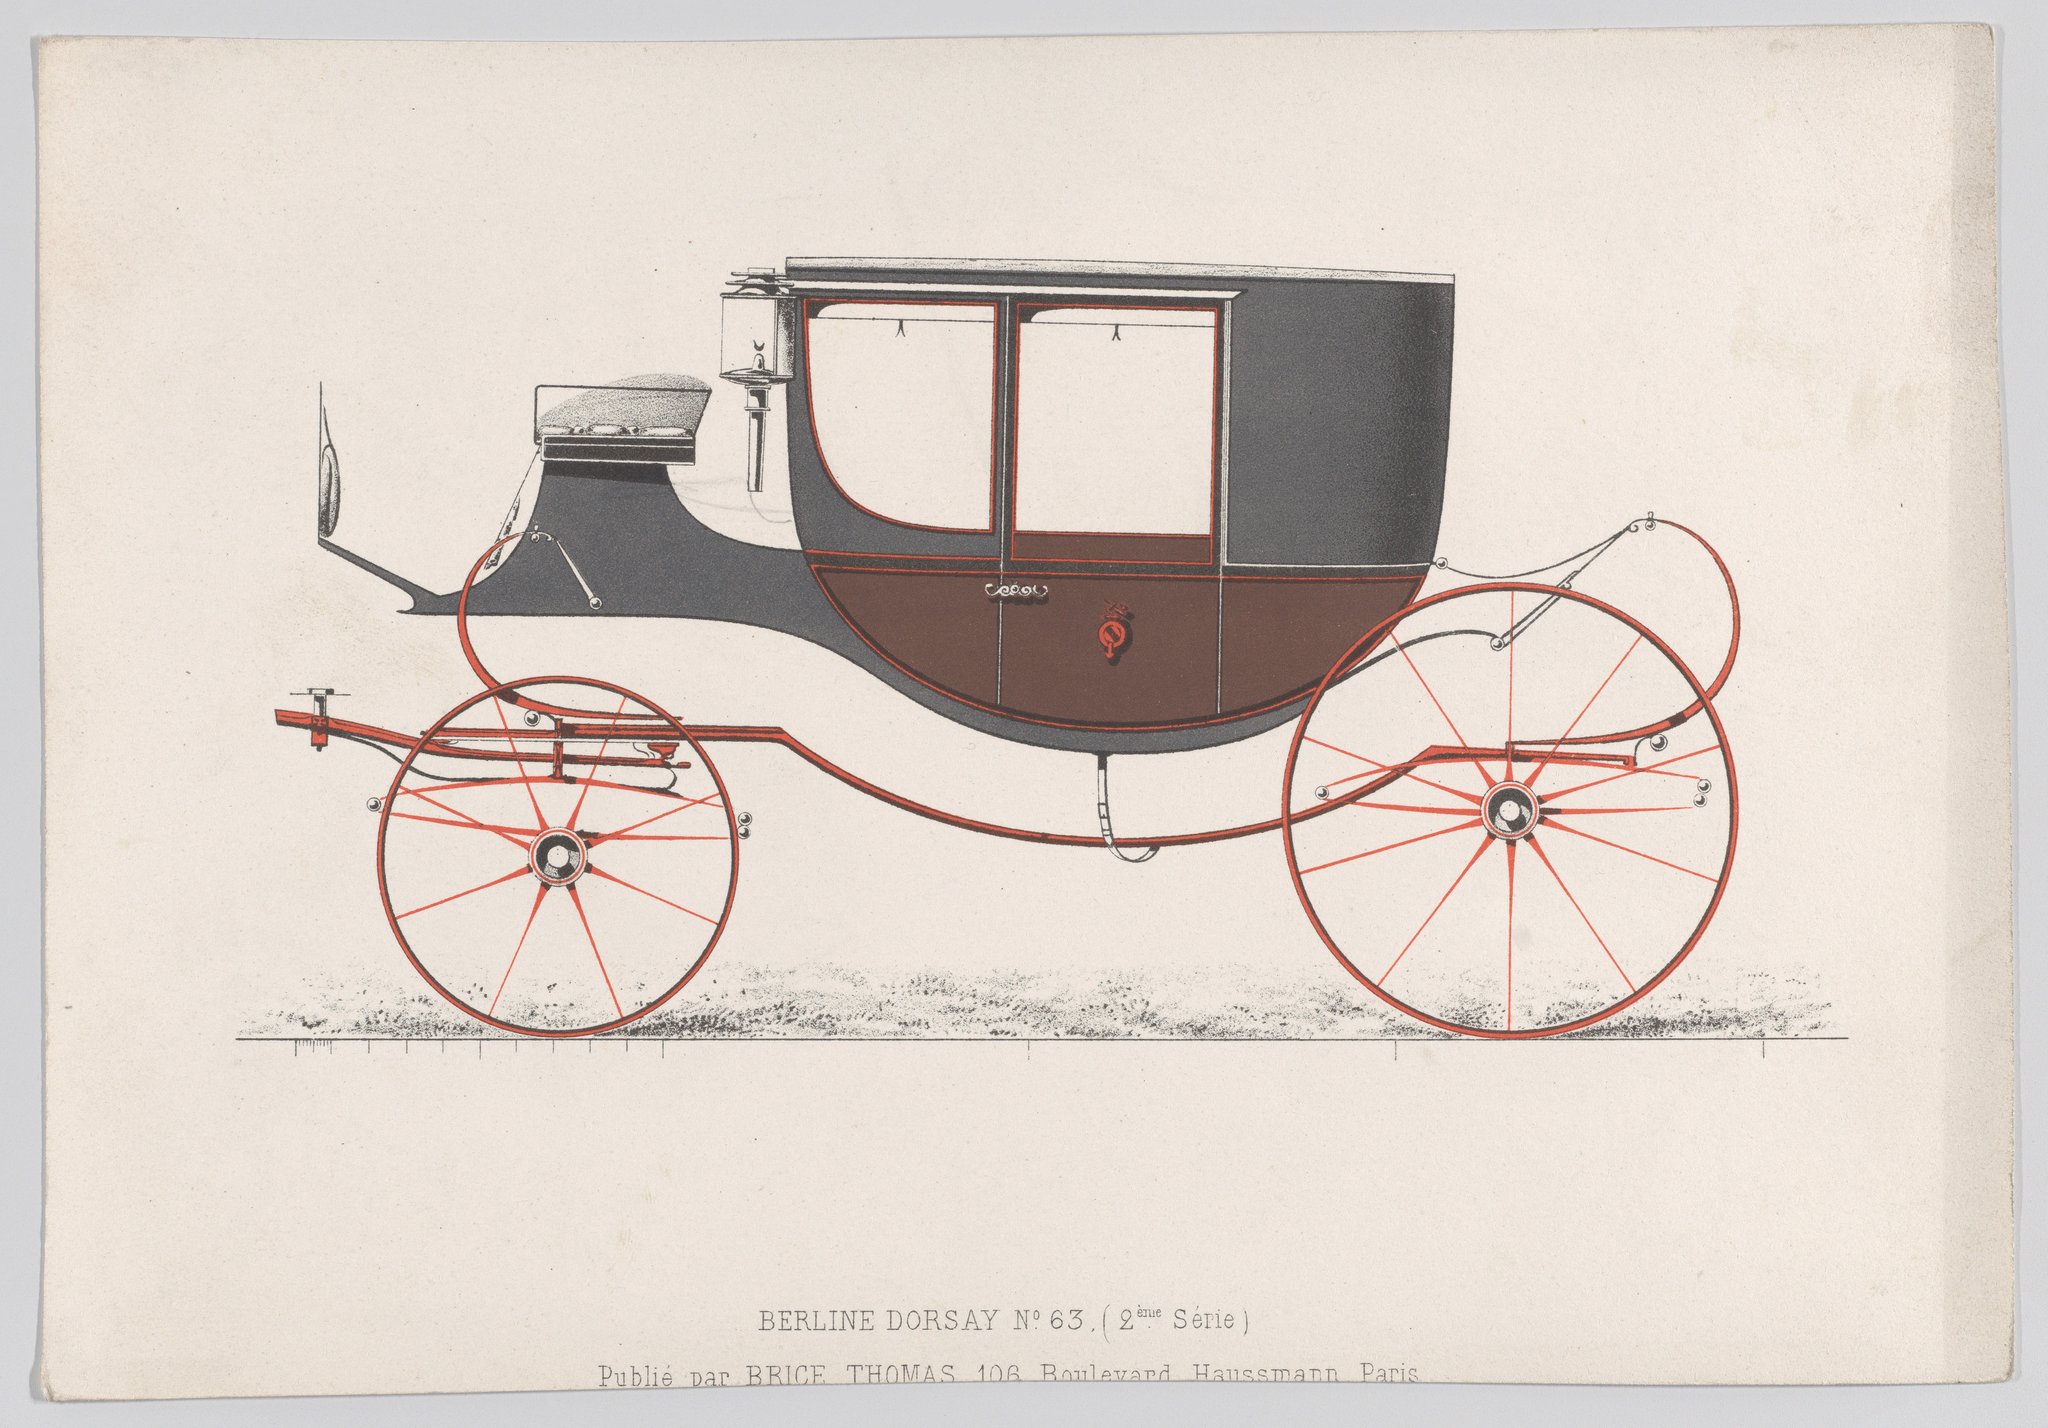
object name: print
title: Design for Coach or Berlin/D'Orsay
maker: anonymous, french, 19th century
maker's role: artist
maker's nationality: french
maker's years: 1800-1900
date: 1870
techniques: hand coloring, lithograph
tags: carriages